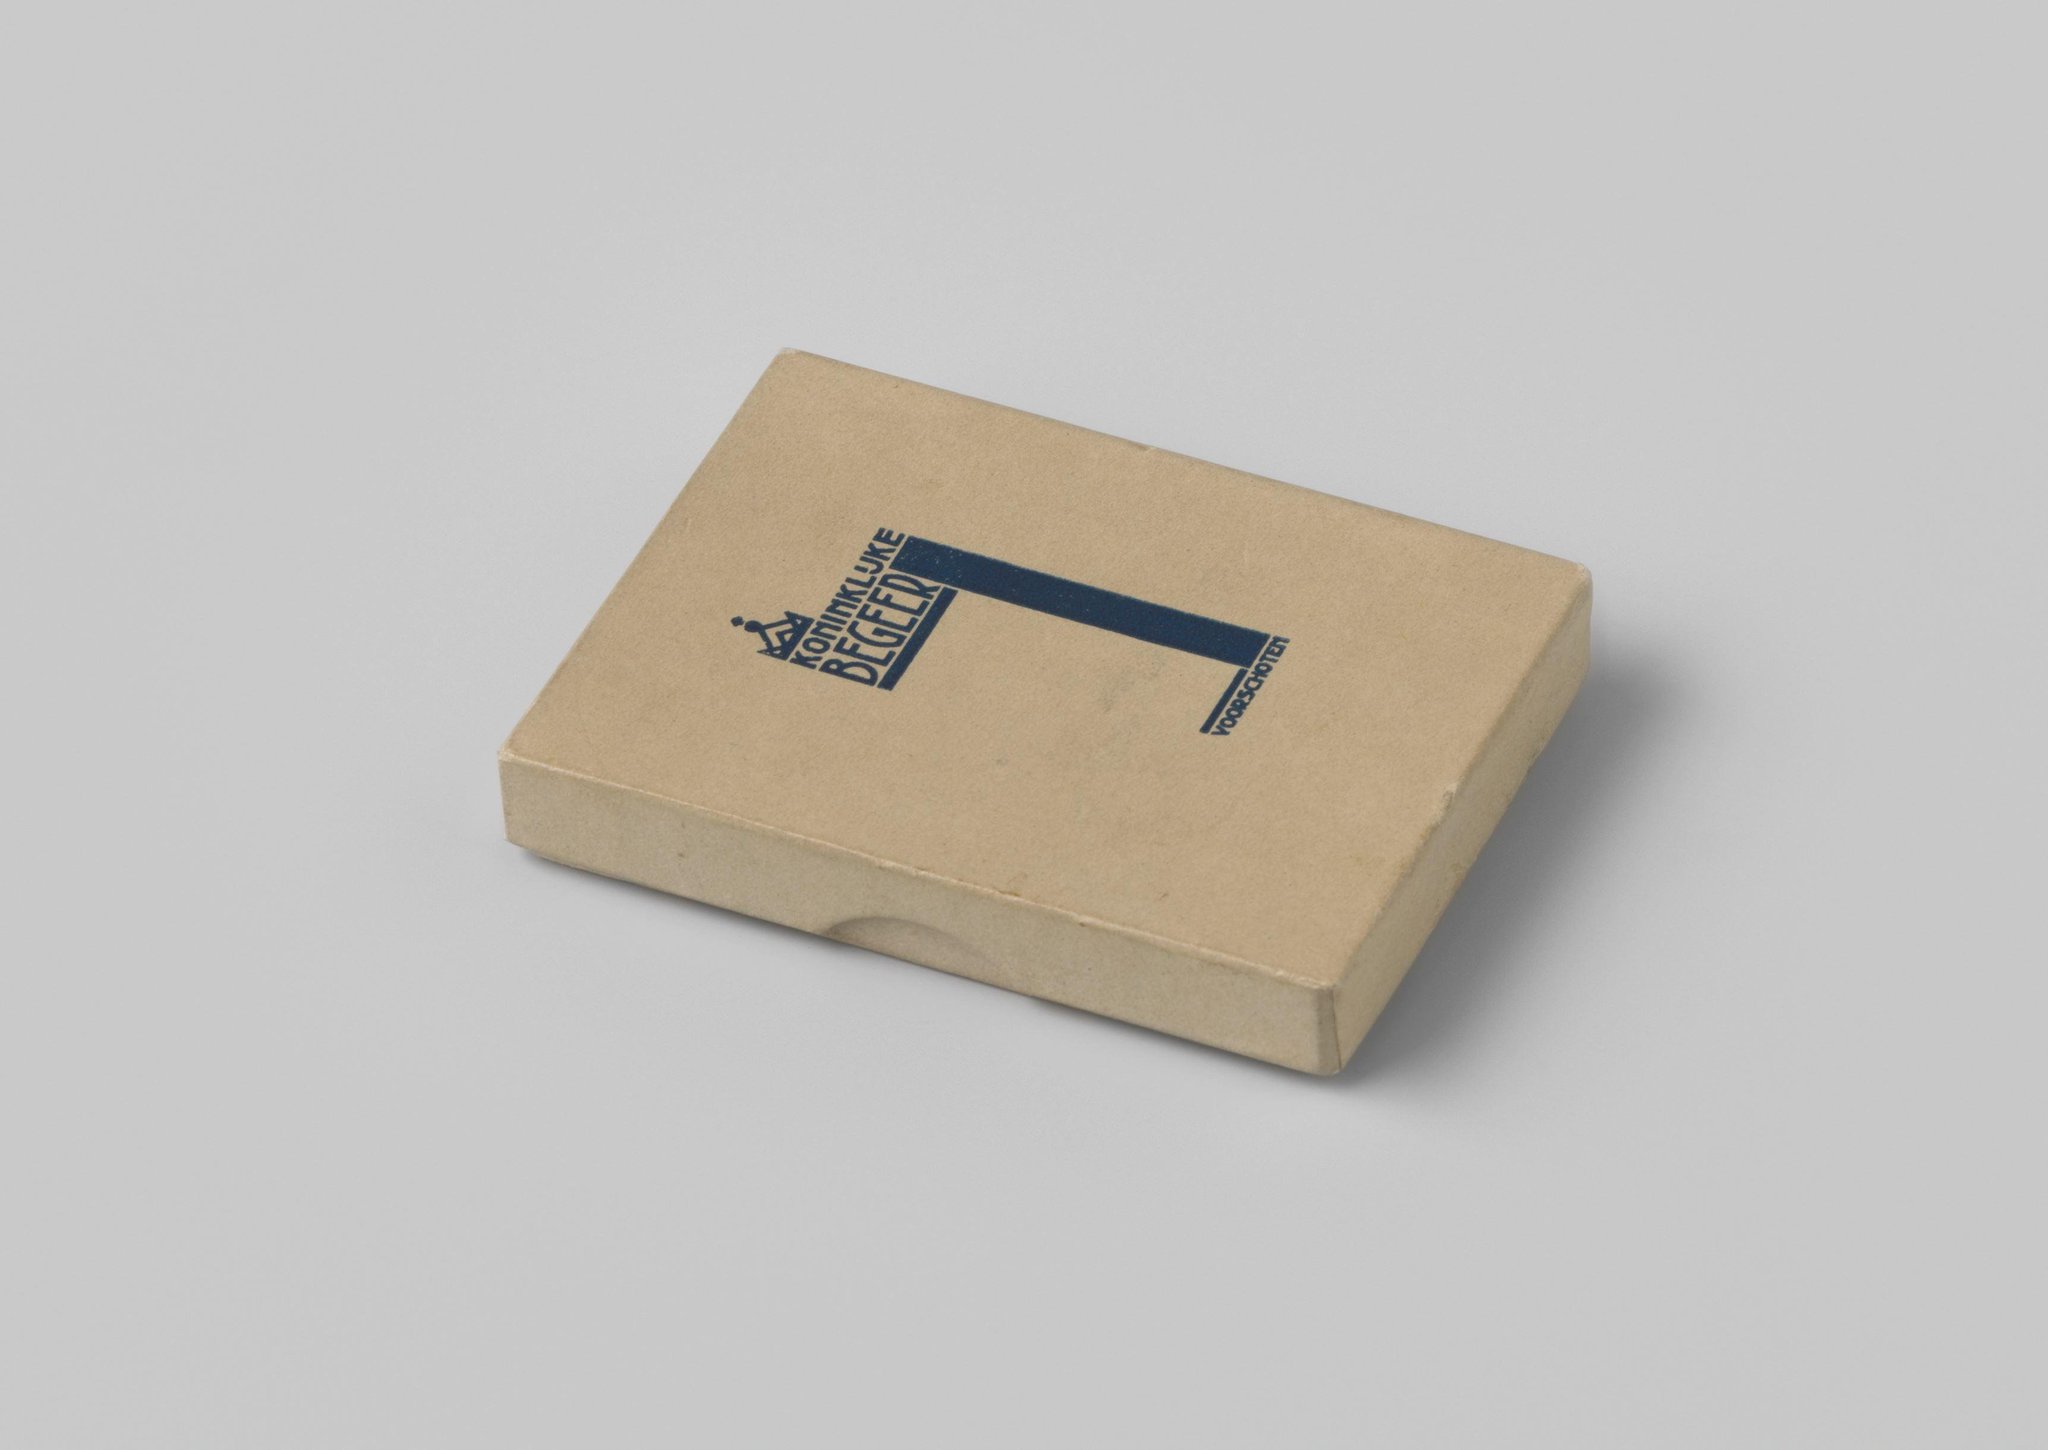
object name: box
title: Doos behorend bij een plaquette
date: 1938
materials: cardboard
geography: voorschoten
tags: amsterdam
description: Wit rechthoekig doosje met op de deksel in blauwe letters geschreven KONINKLIJKE BEGEER VOORSCHOTEN.